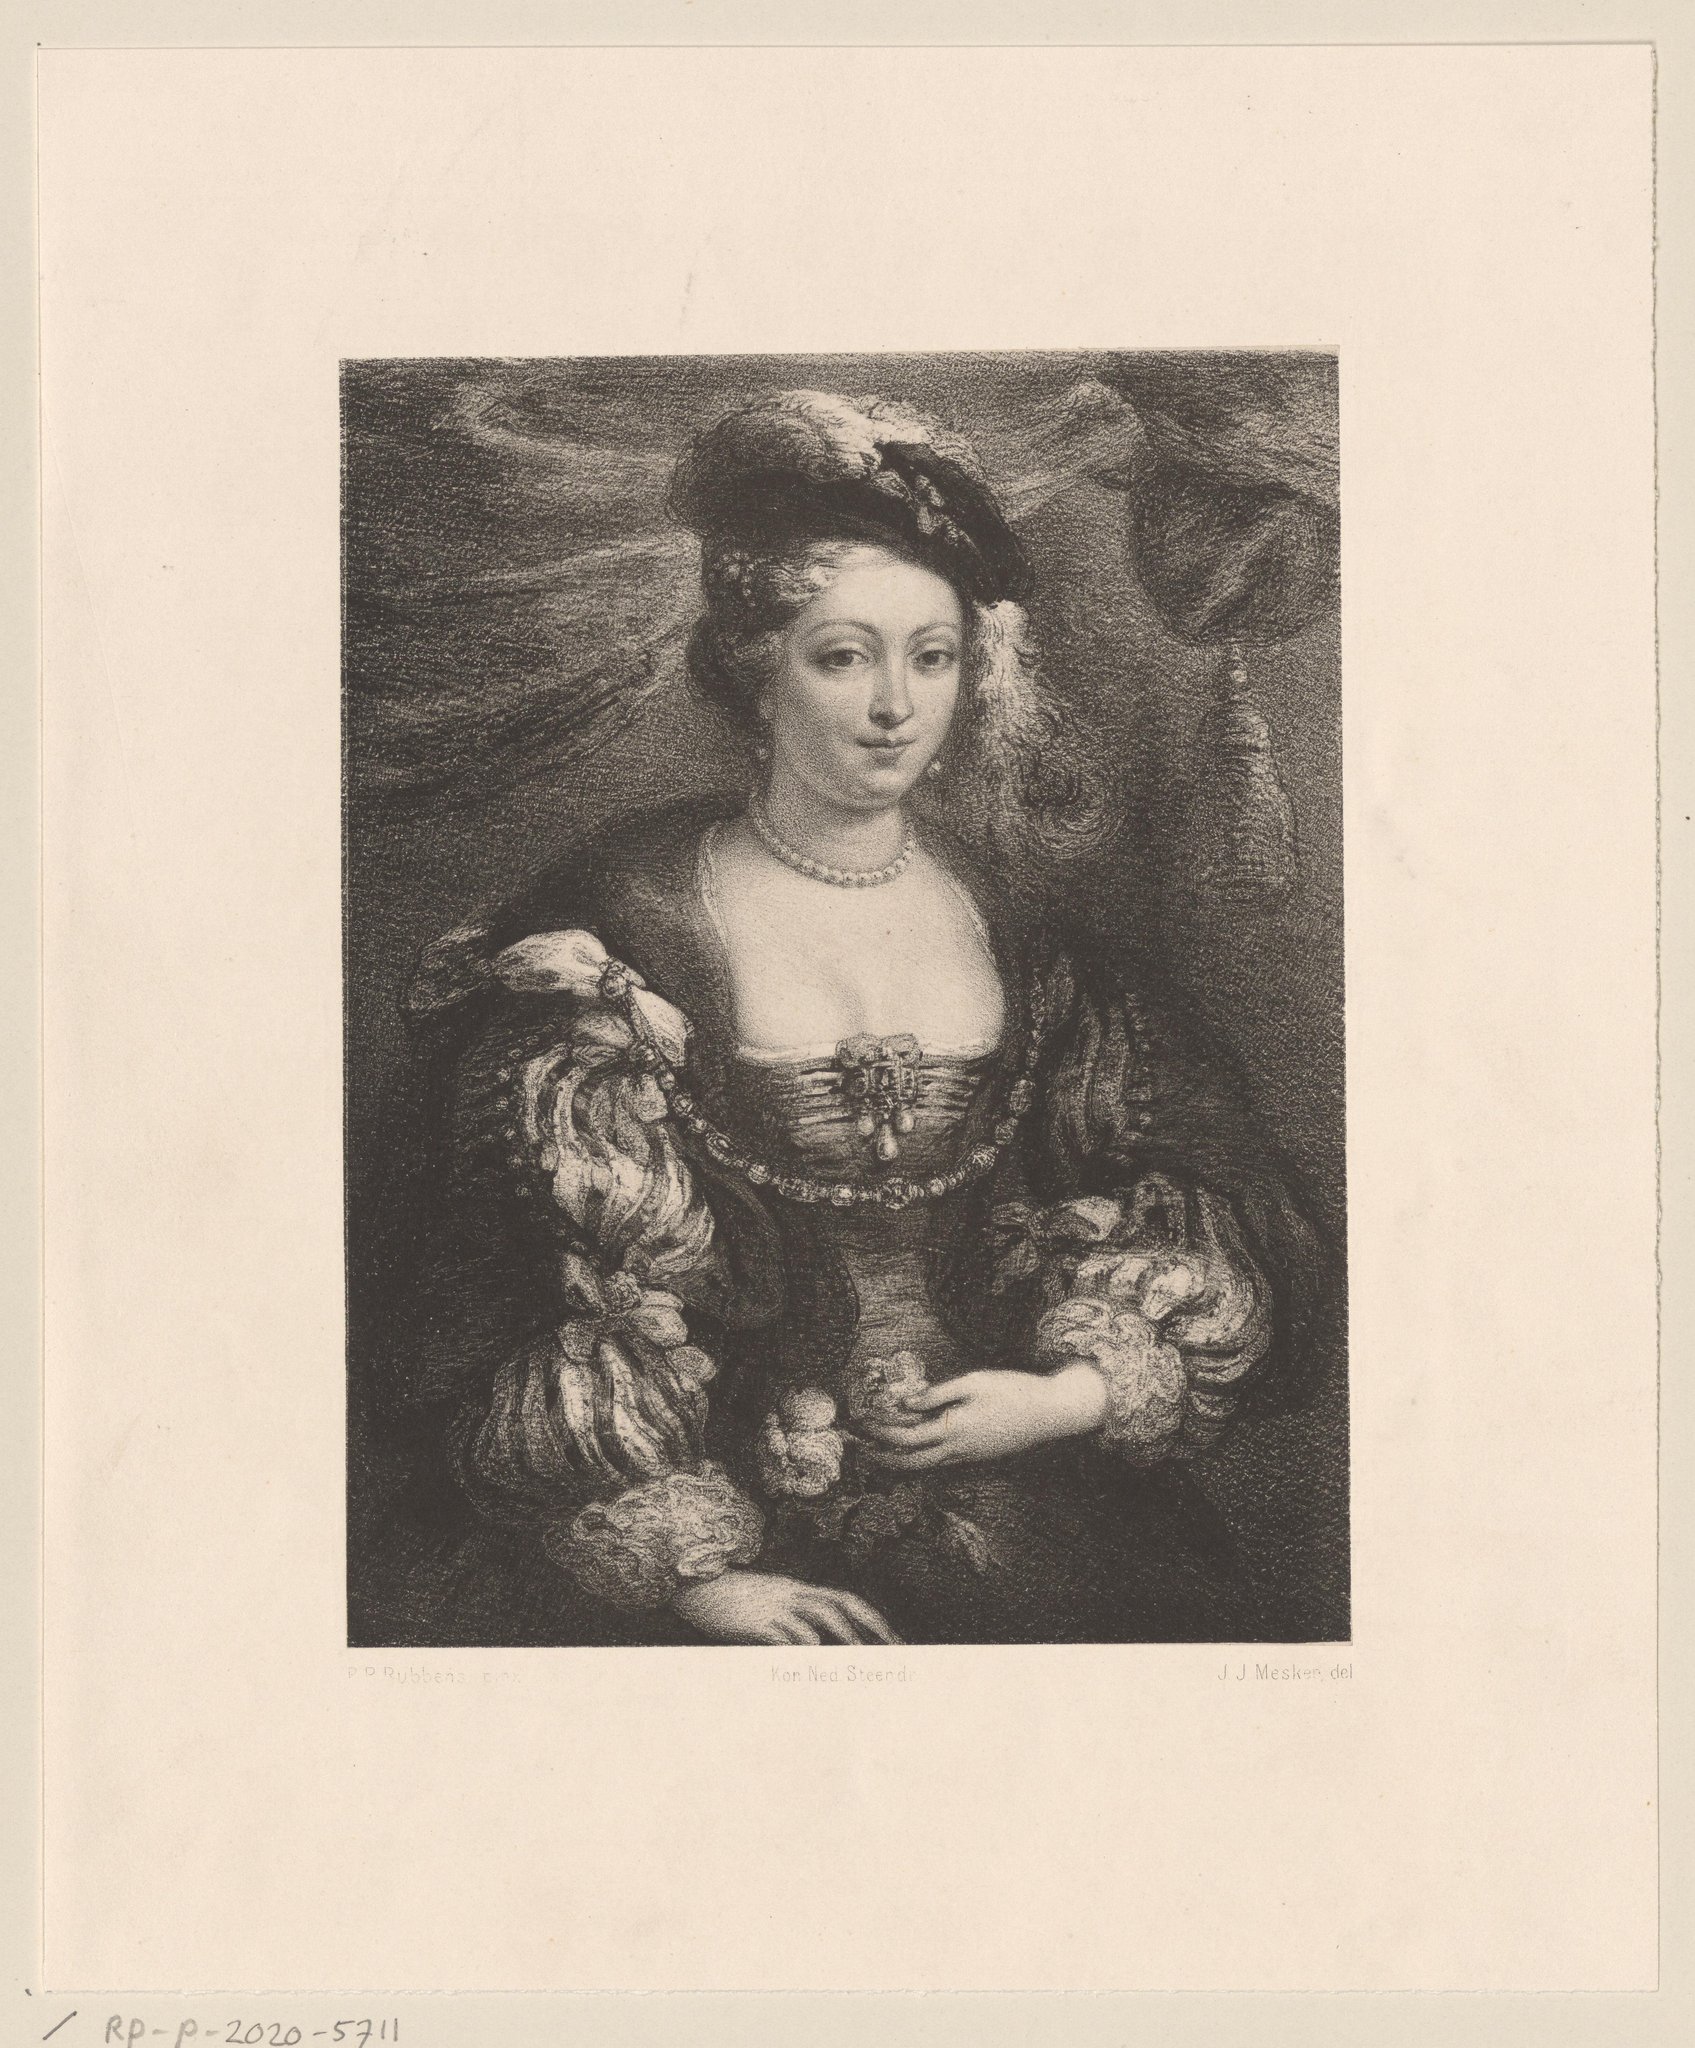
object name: print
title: Portret van Hélène Fourment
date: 1867-1874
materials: paper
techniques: lithograph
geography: the hague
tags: historical persons - bb - woman, head-gear: hat (+ women's clothes), pearl; pearl necklace